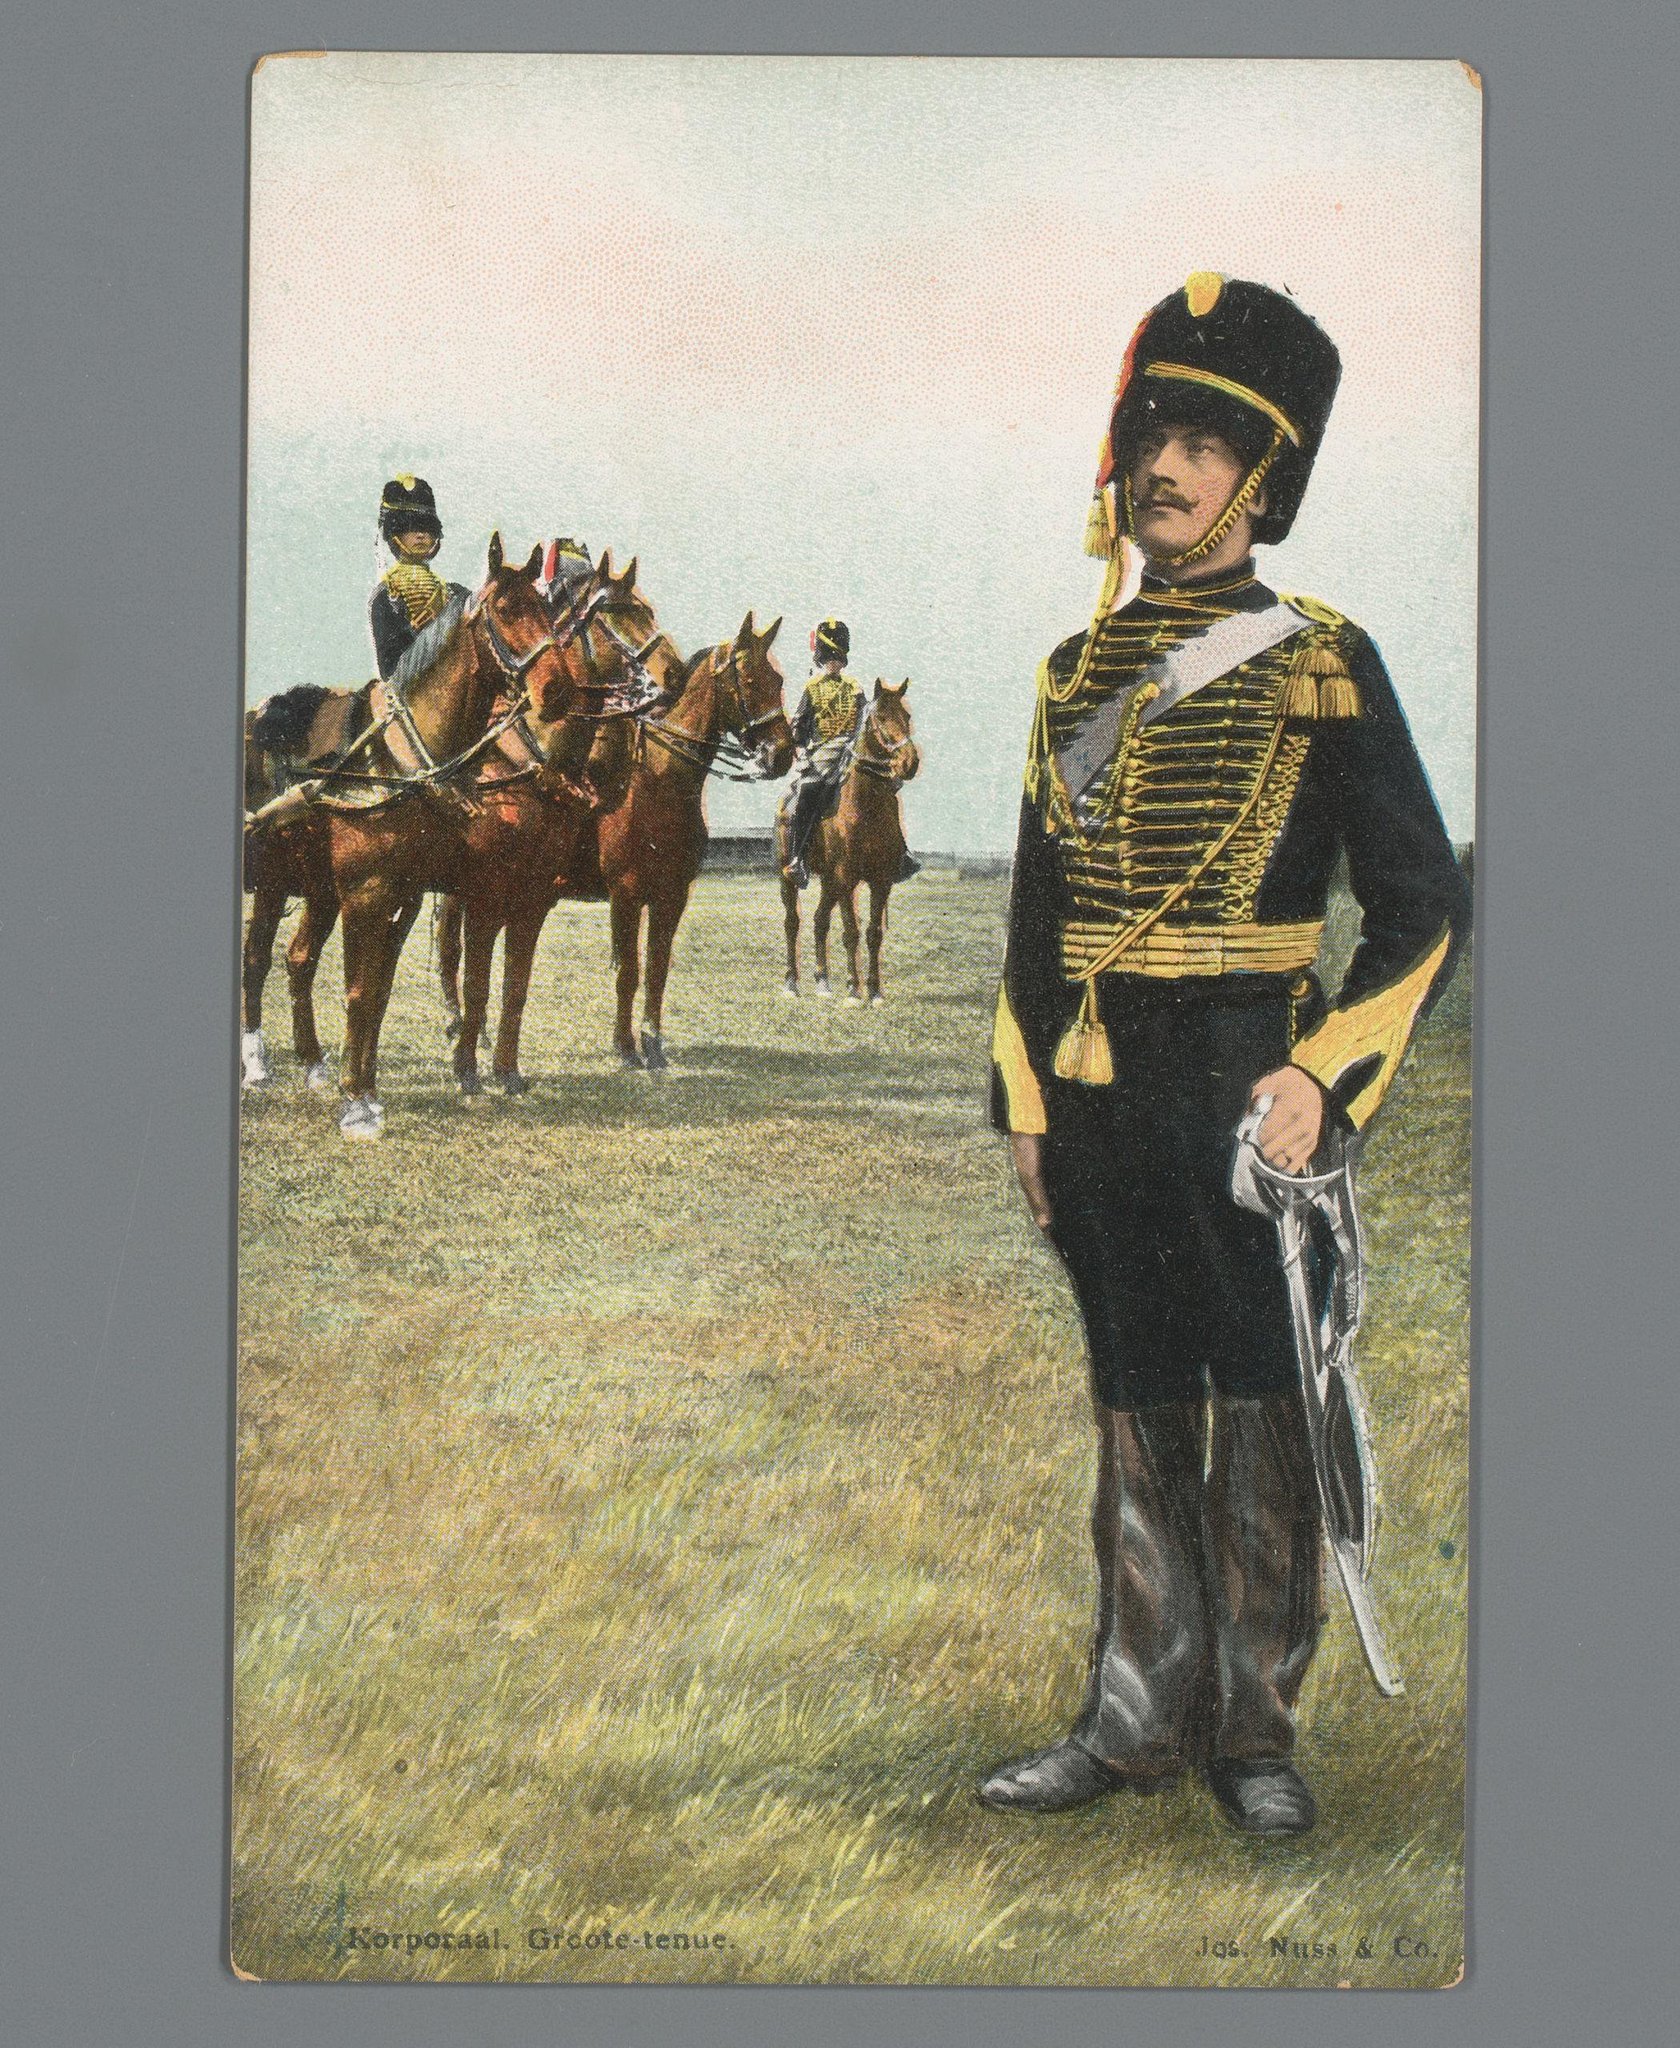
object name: photomechanical print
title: Onze land- en zeemacht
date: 1905-1909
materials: paper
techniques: four-color autotype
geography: haarlem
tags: anonymous historical person portrayed, officer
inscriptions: inscription: ‘BRIEFKAART/ (CARTE POSTALE)/ Algemeene Postvereeniging (Union postale universelle)/ DRUKWERK/ No. 6 AUTEURSRECHT VERZEKERD OVEREENKOMSTIG/ DE WET, 28 JUNI 1881, STAATSBLAD NO 124 .'./ Bij verzending/ als "drukwerk" de/ woorden briefkaart/ carte postale door-/ schrappen en alleen/ naam en datum/ er op schrijven.’, inscription: ‘68, uniform’